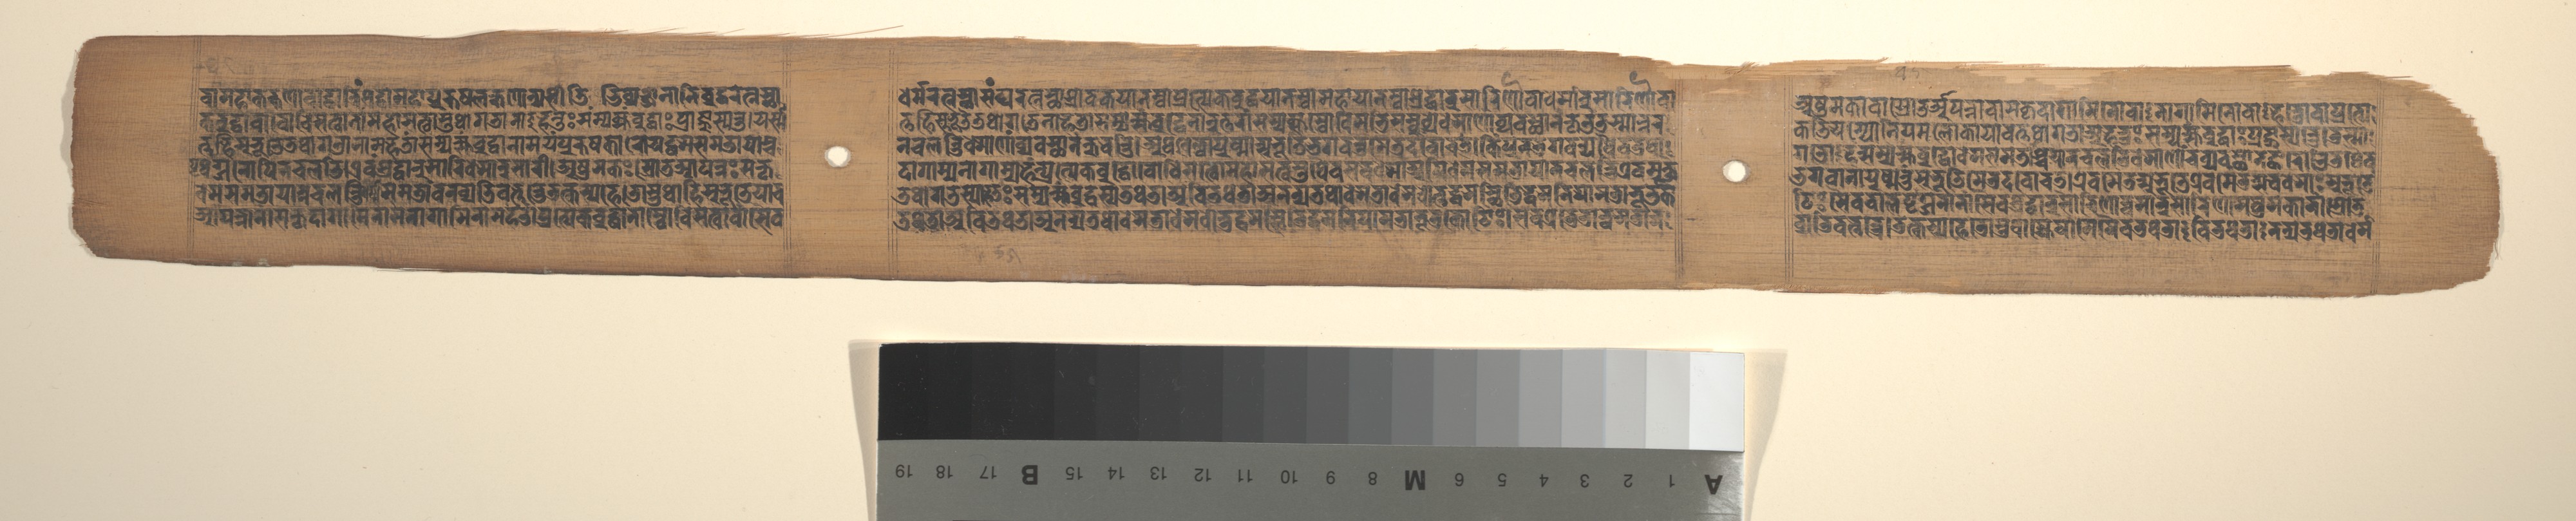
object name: folio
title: Folio from a Buddhist Manuscript of Pancavimsatisahasrika Prajnaparamita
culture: indian, bengal or bangladesh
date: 1090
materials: leaf, watercolor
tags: buddhism